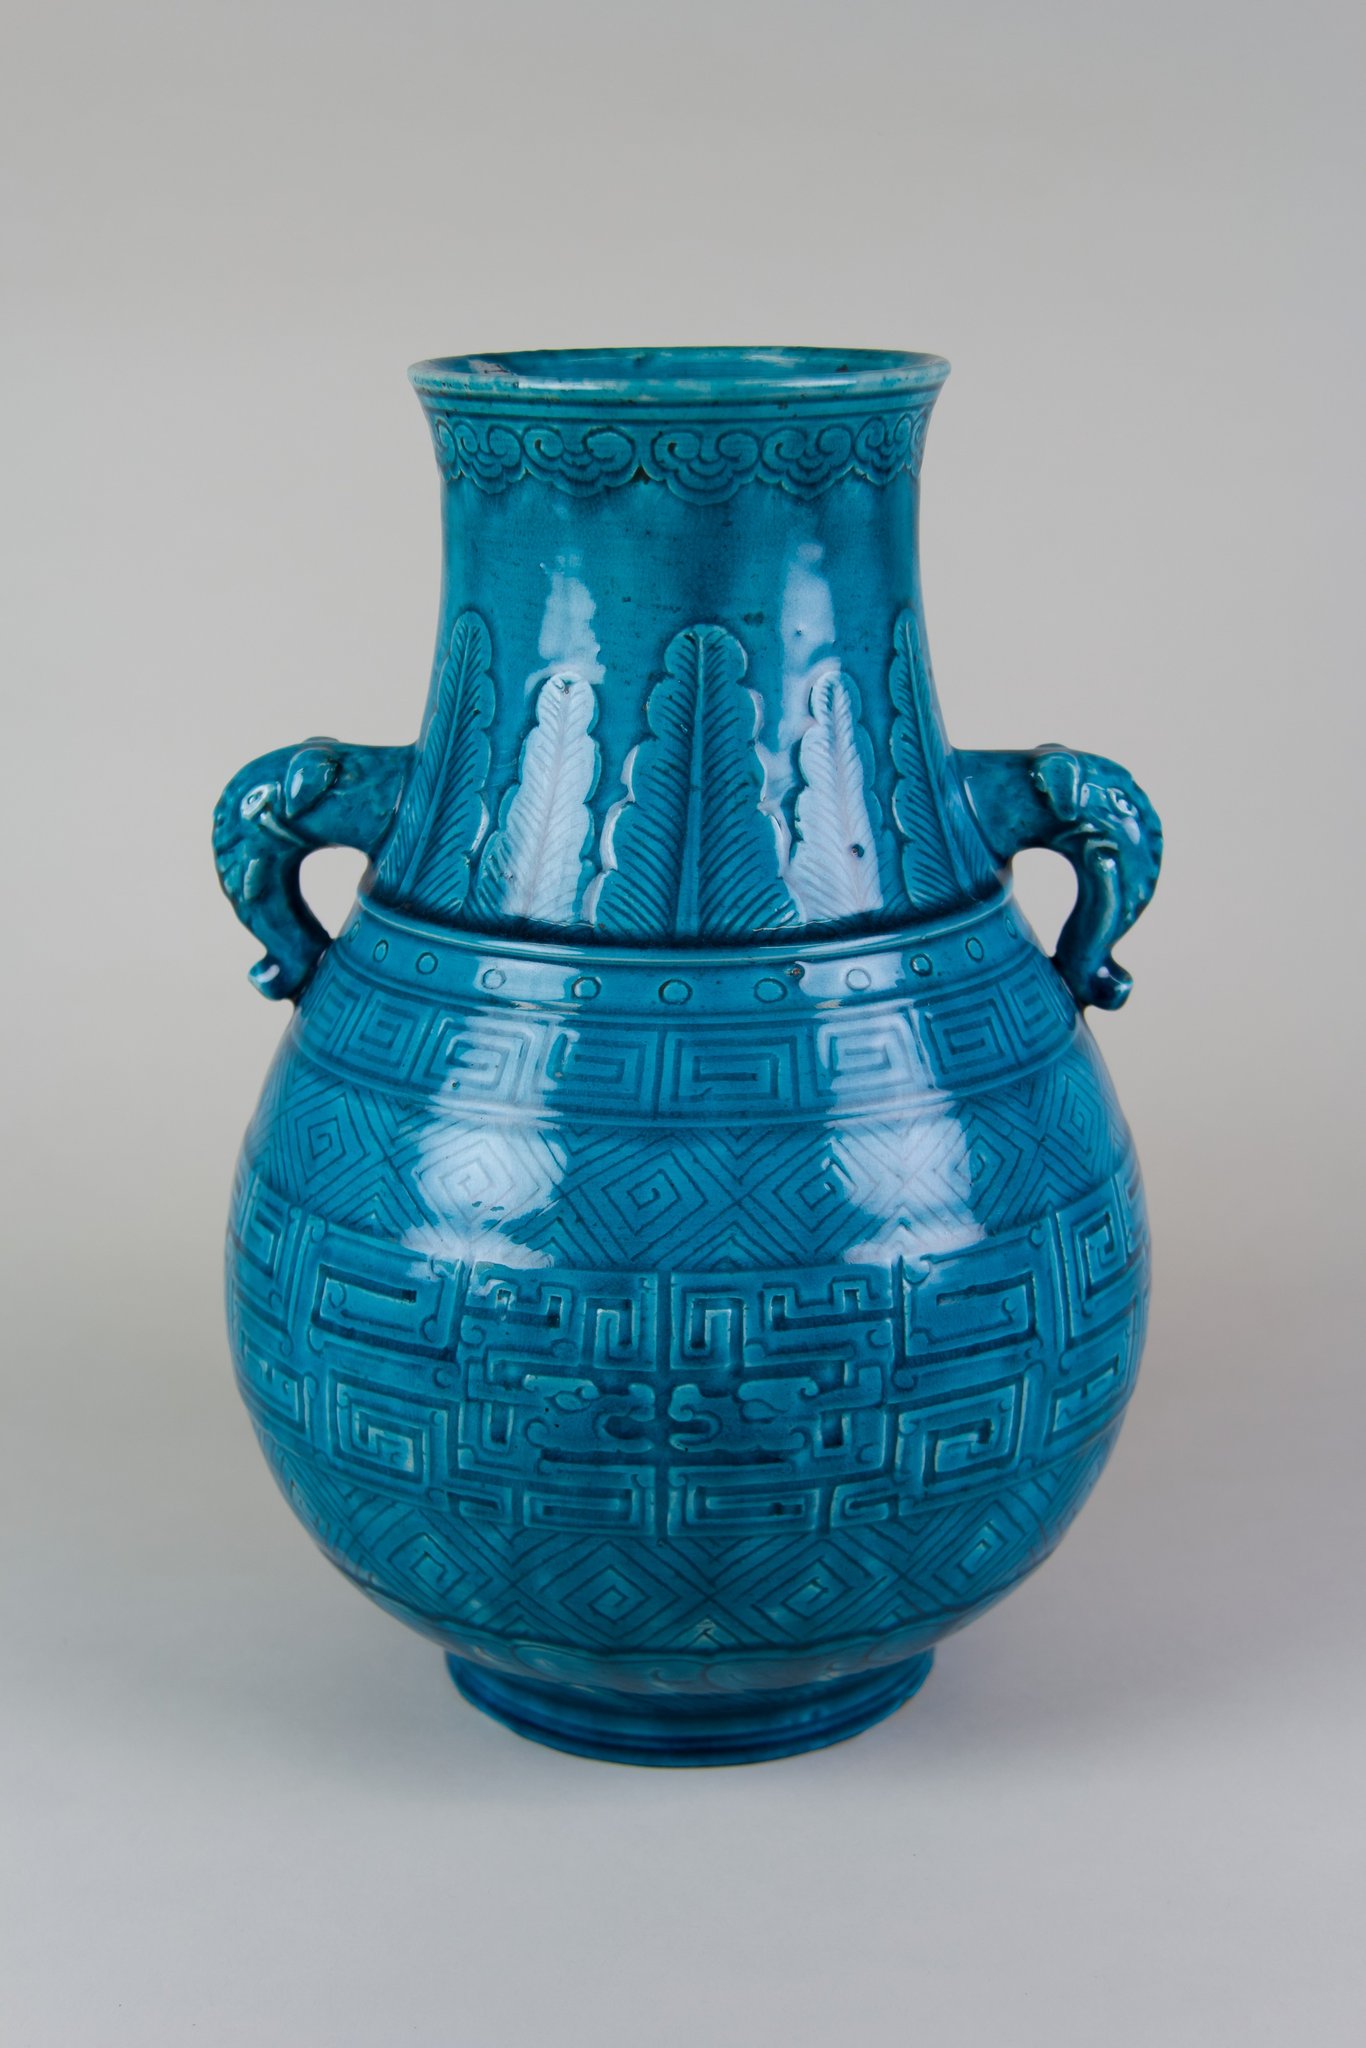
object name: vase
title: Vase with archaistic design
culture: chinese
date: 1767-1800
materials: glaze, porcelain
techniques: relief